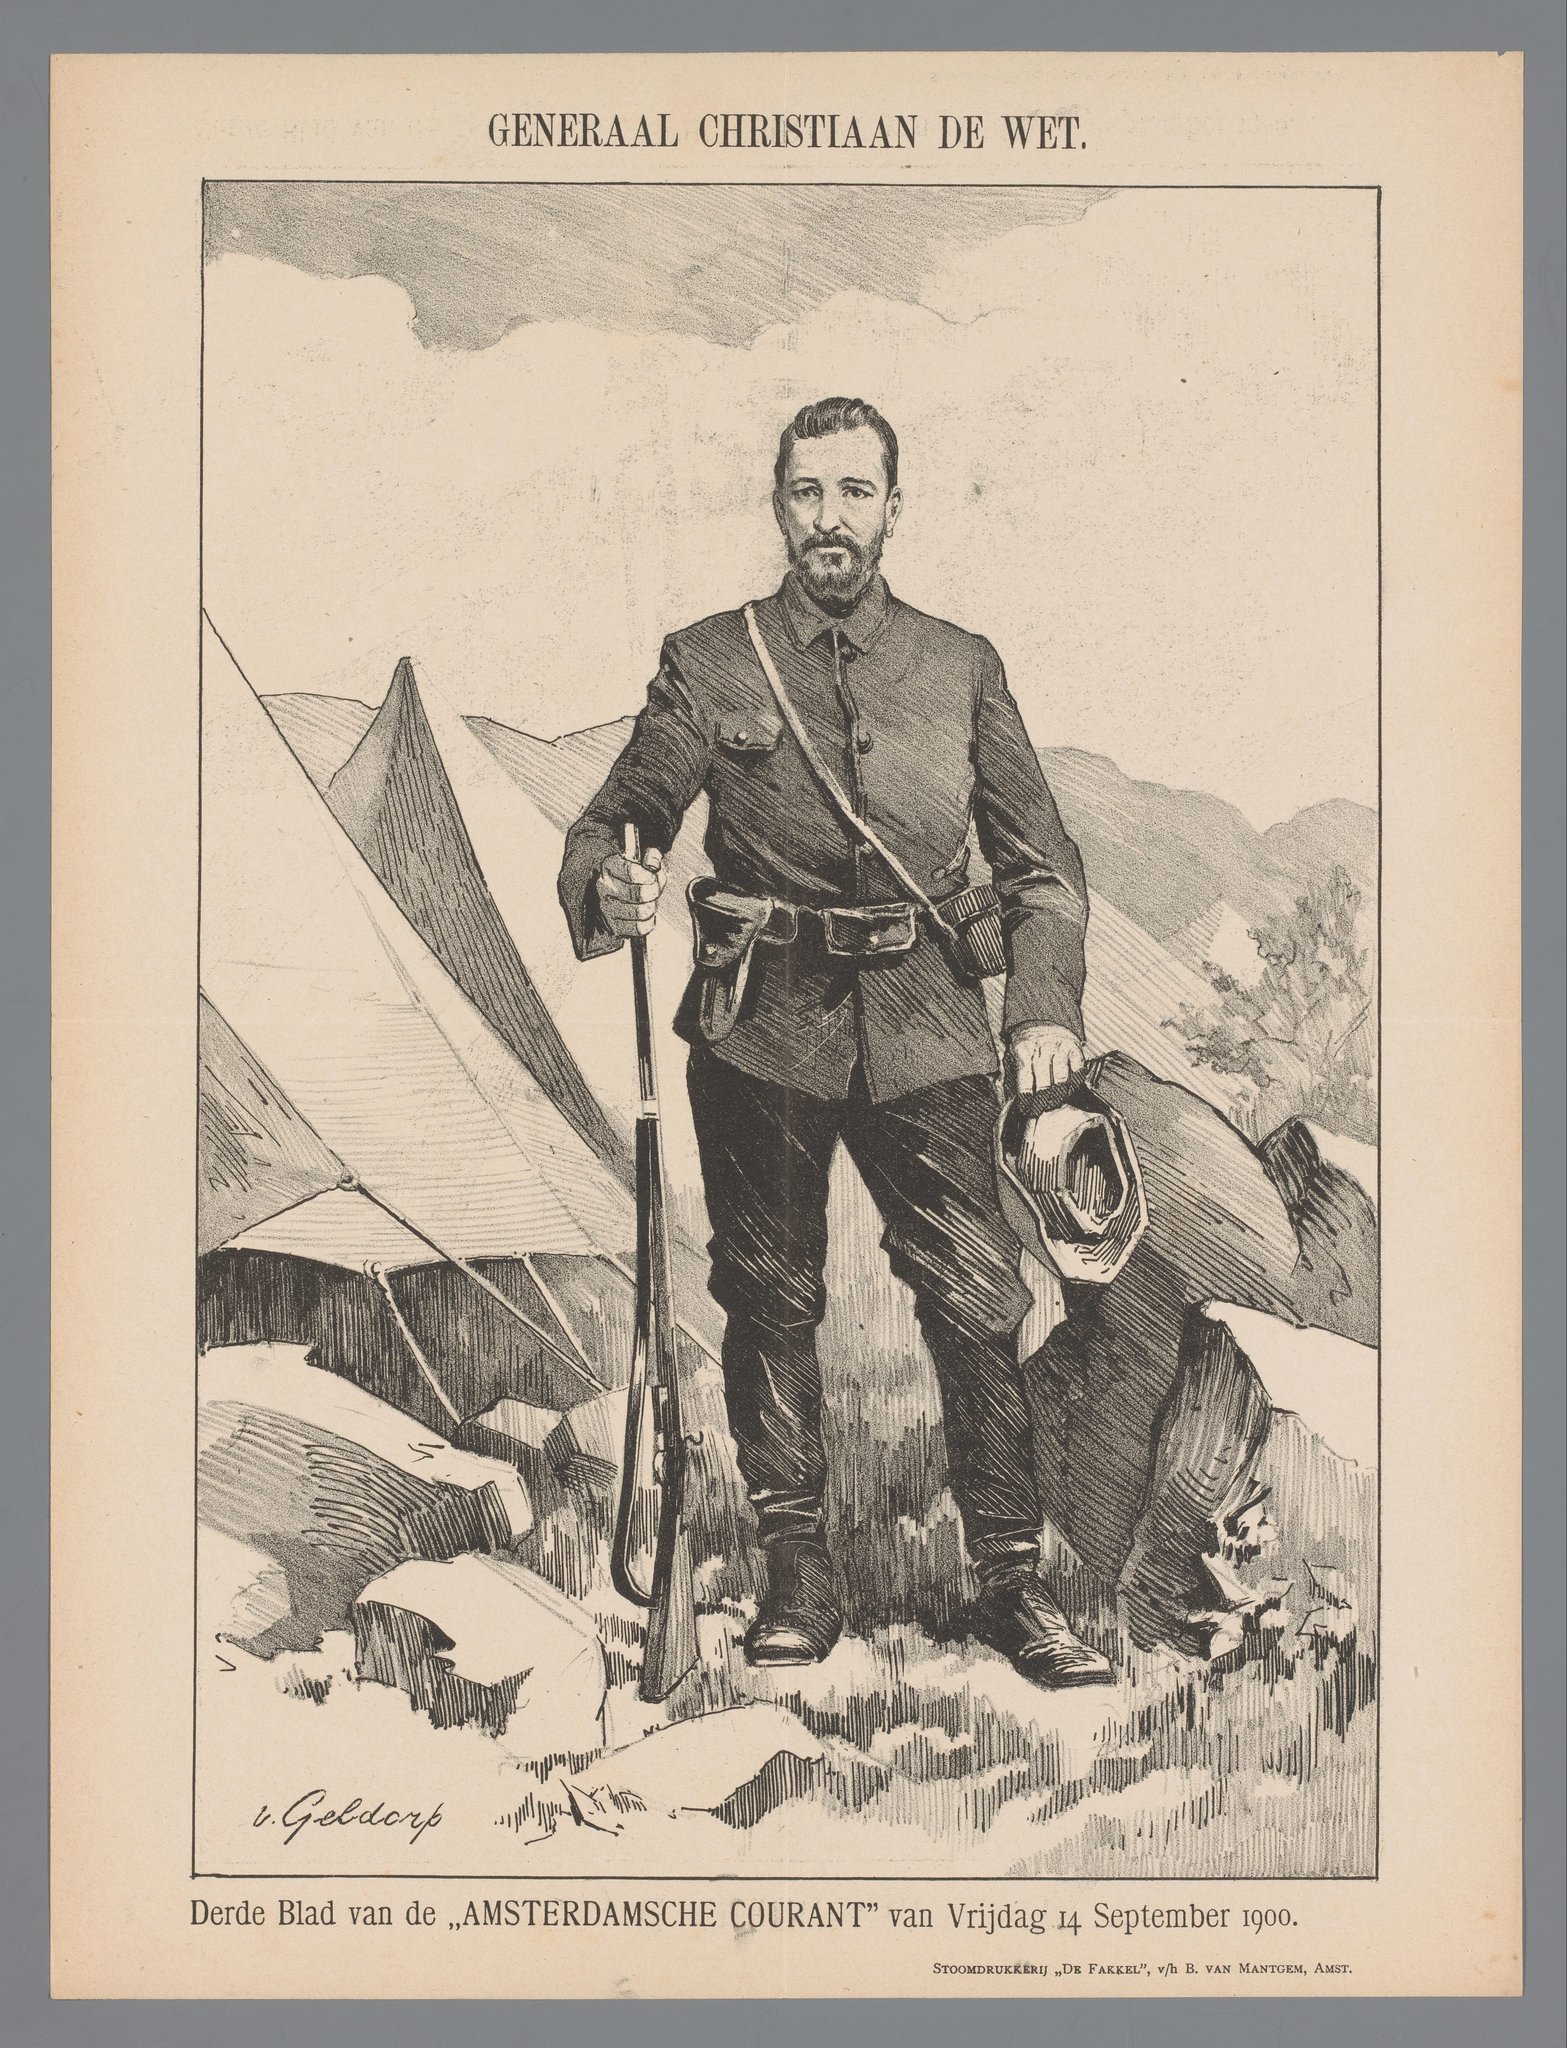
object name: print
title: Generaal Christiaan de Wet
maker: petrus van geldorp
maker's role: draughtsman, print maker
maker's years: 1872-1939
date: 1900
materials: paper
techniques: lithograph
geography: amsterdam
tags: politician, commander-in-chief, general, marshal, historical persons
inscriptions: date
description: Prent uit het bijvoegsel van: De Amsterdamsche Courant, 14 september 1900.